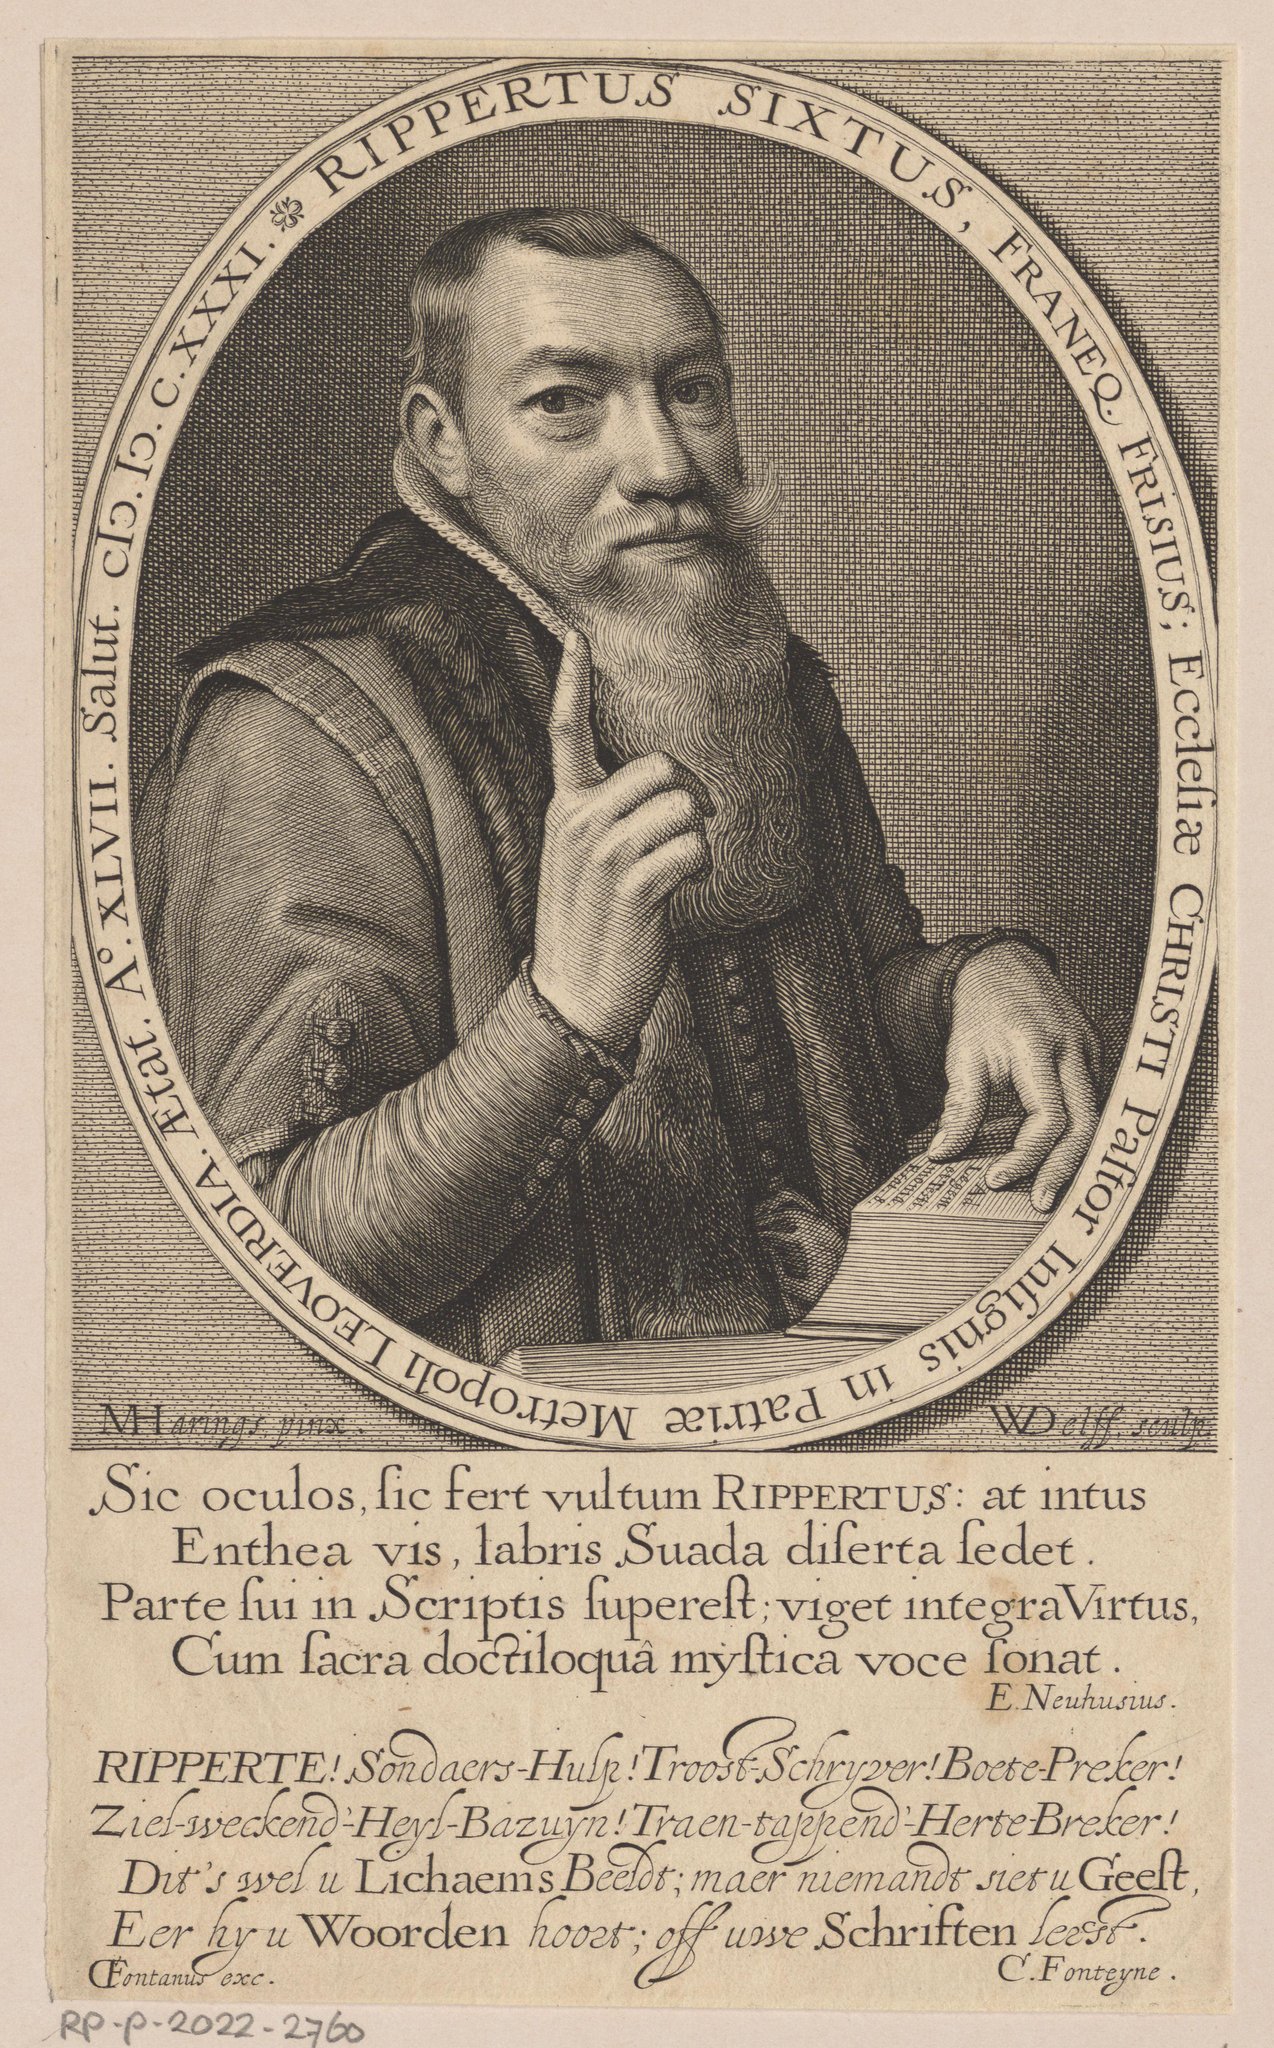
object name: print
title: Portret van Rippertus Sixtus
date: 1631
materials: paper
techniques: engraving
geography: delft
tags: historical persons, functionaries and dignitaries (with name) ~ episcopal protestant churches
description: Met achtregelig onderschrift in het Latijn en het Nederlands en tekst in het Latijn rondom het portret.